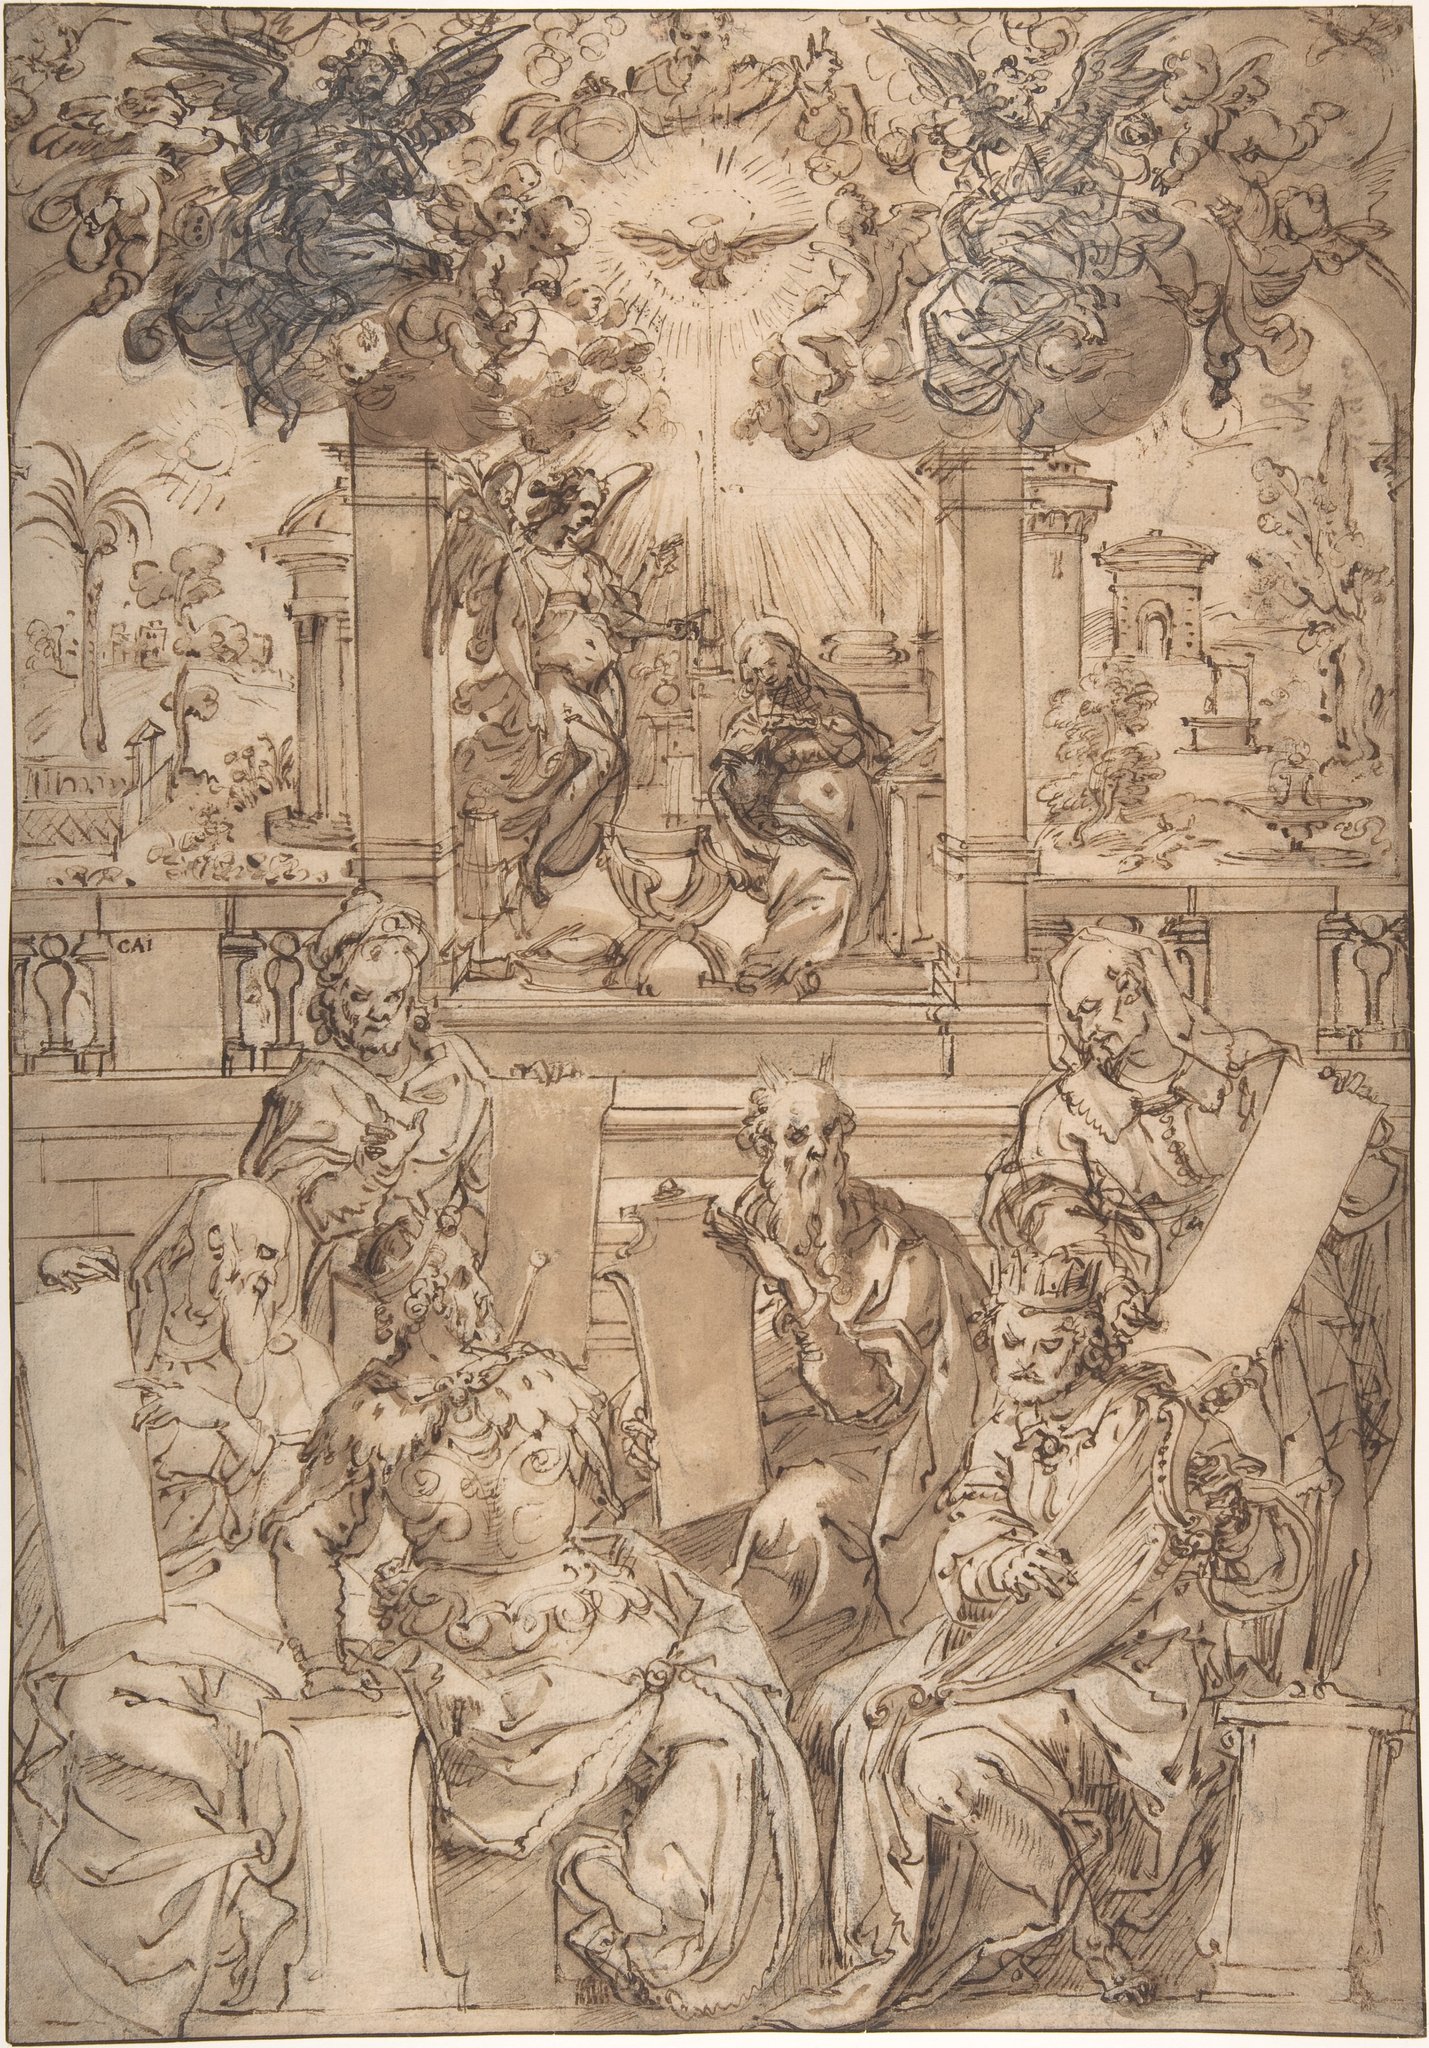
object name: drawing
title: The Six Prophets of the Coming of Christ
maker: jan van der straet, called stradanus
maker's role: artist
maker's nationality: netherlandish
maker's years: 1523-1605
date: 1534-1633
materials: chalk, ink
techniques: brush, pen, wash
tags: men,harps,angels,christ